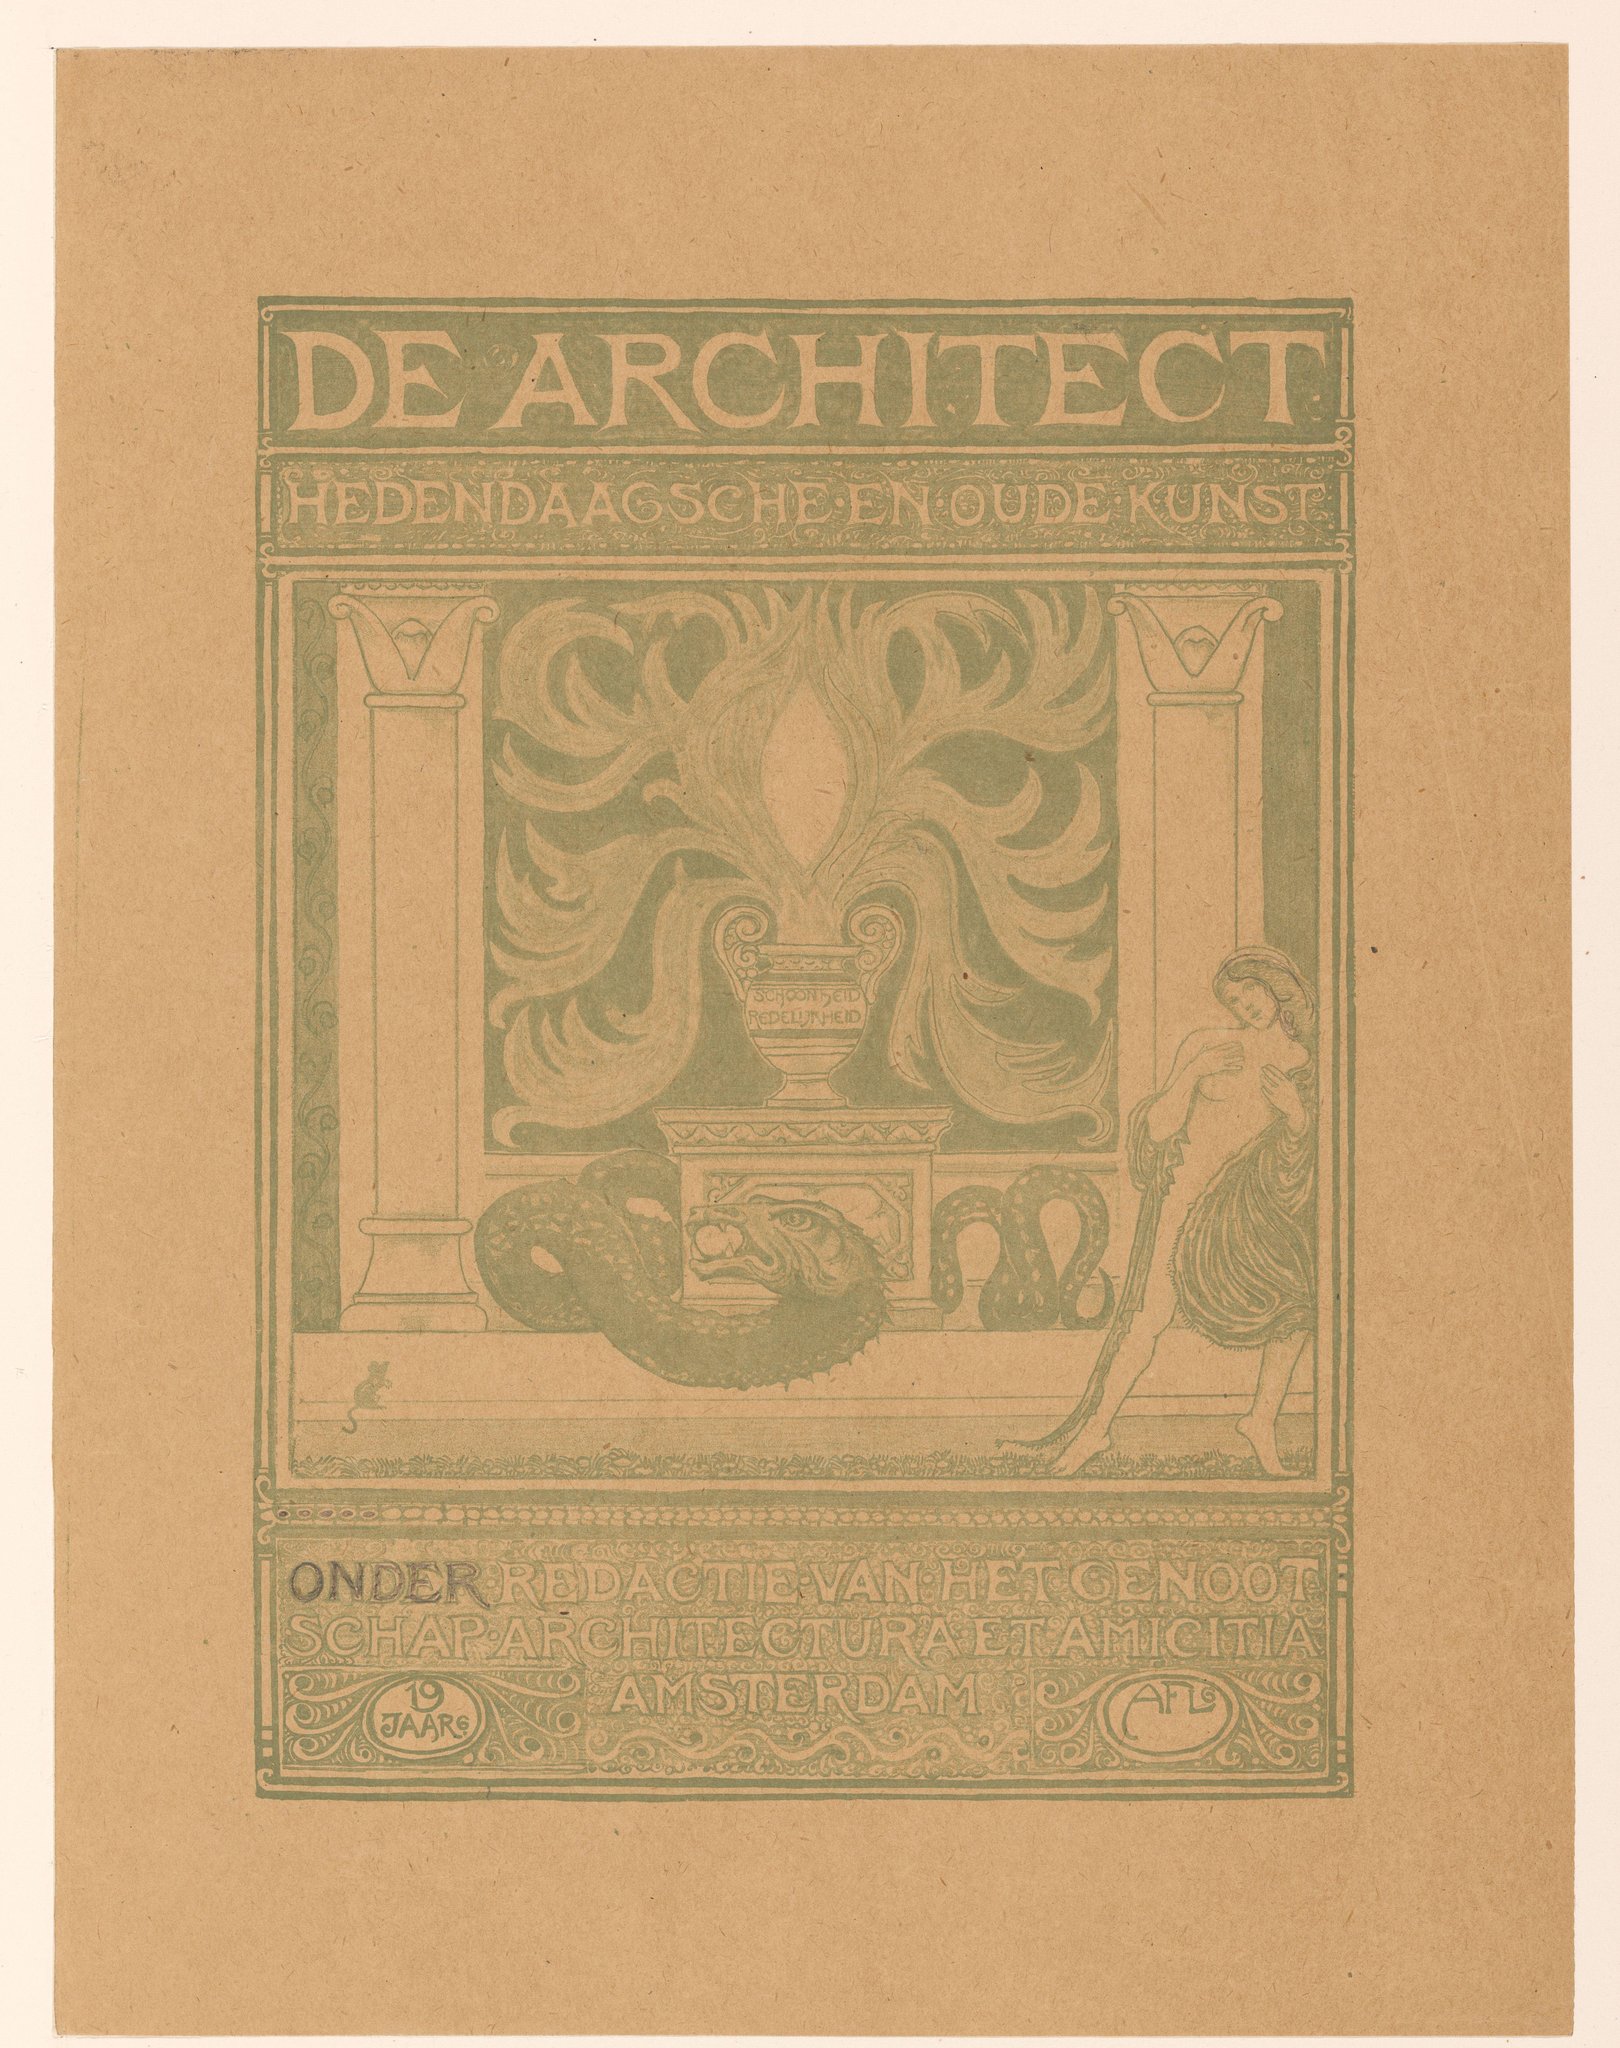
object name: print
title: Omslagontwerp voor: De Architect, 1911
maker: richard nicolaüs roland holst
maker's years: 1868-1938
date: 1911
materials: chalk, paper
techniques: lithograph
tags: snakes, column, pillar ~ architecture, open fire (in general), woman (showing herself) undressed, quasi-nude, container of ceramics: jar, jug, pot, vase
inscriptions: collector's mark: Lugt 2228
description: Een rechthoekig kader met daarin een slang die zich om een sokkel heeft gewikkeld waarop een kruik staat waarin een vuur brandt. Op de kruik de woorden 'SCHOONHEID' en 'REDELIJKHEID'. Links op de voorgrond een muis, rechts op de voorgrond een staande, naakte vrouw.